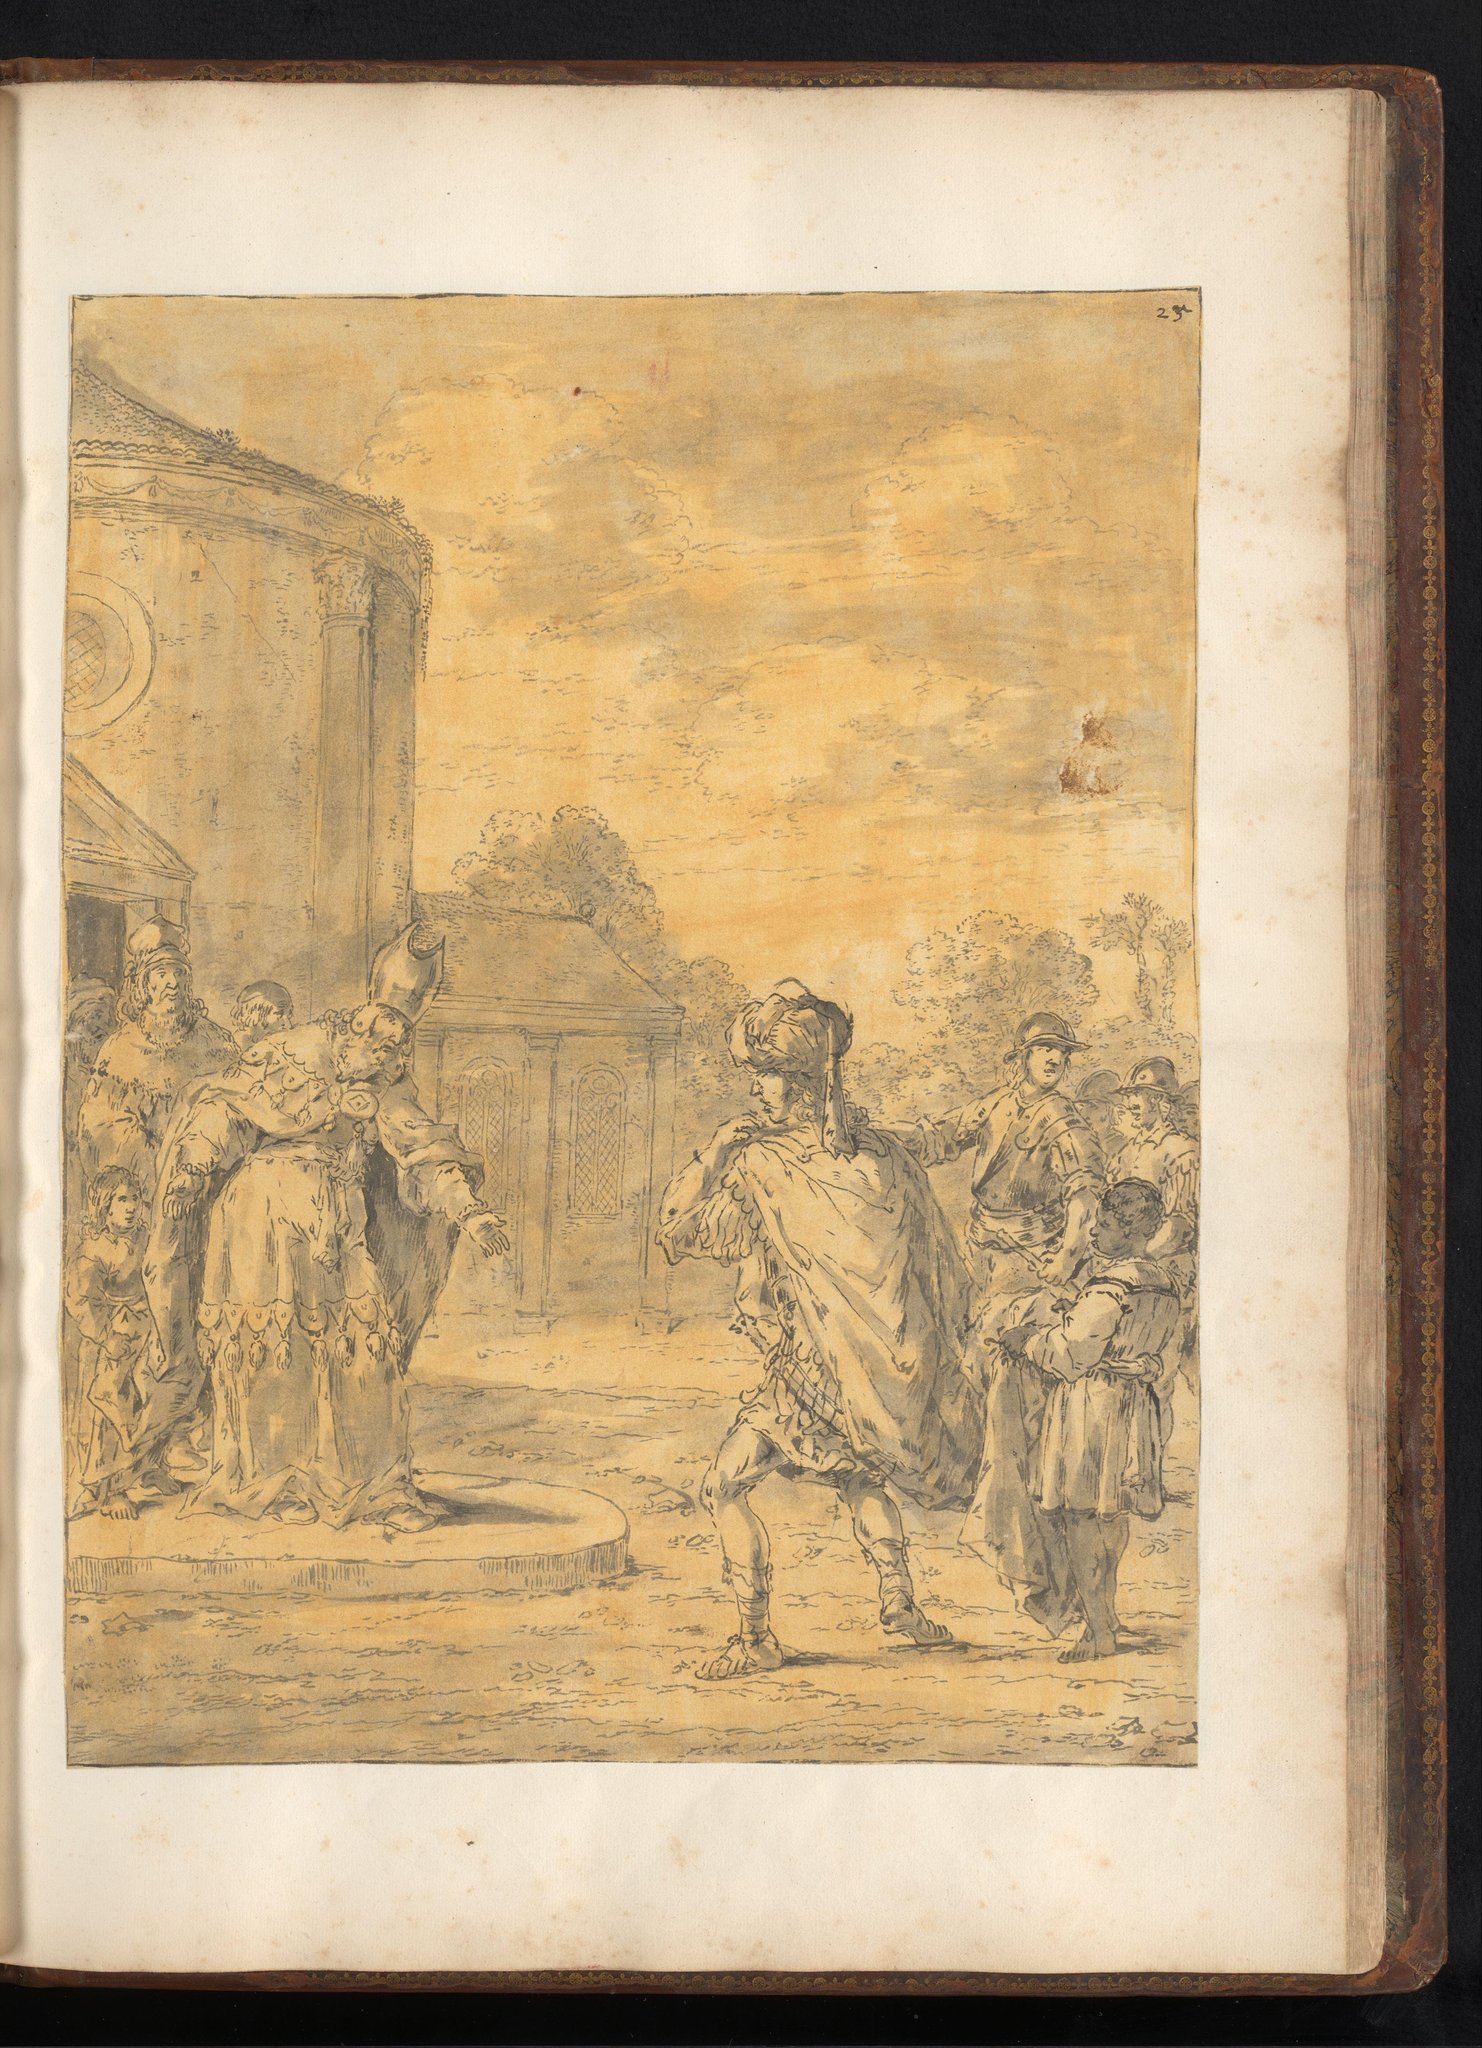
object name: drawing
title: Alexander de Grote bezoekt de tempel van Jupiter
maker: leonaert bramer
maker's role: draughtsman, painter, print maker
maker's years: 1596-1674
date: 1655-1665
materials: ink, paper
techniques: brush, pen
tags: (story of) alexander the great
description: Rechts staat Alexander de Grote, gevolgd door zijn page en soldaten. Hij wordt begroet door de hoge priester links, die met enkele andere priesters voor de tempel staat. Rechtsboven genummerd: 25. Tekening maakt deel uit van een album.